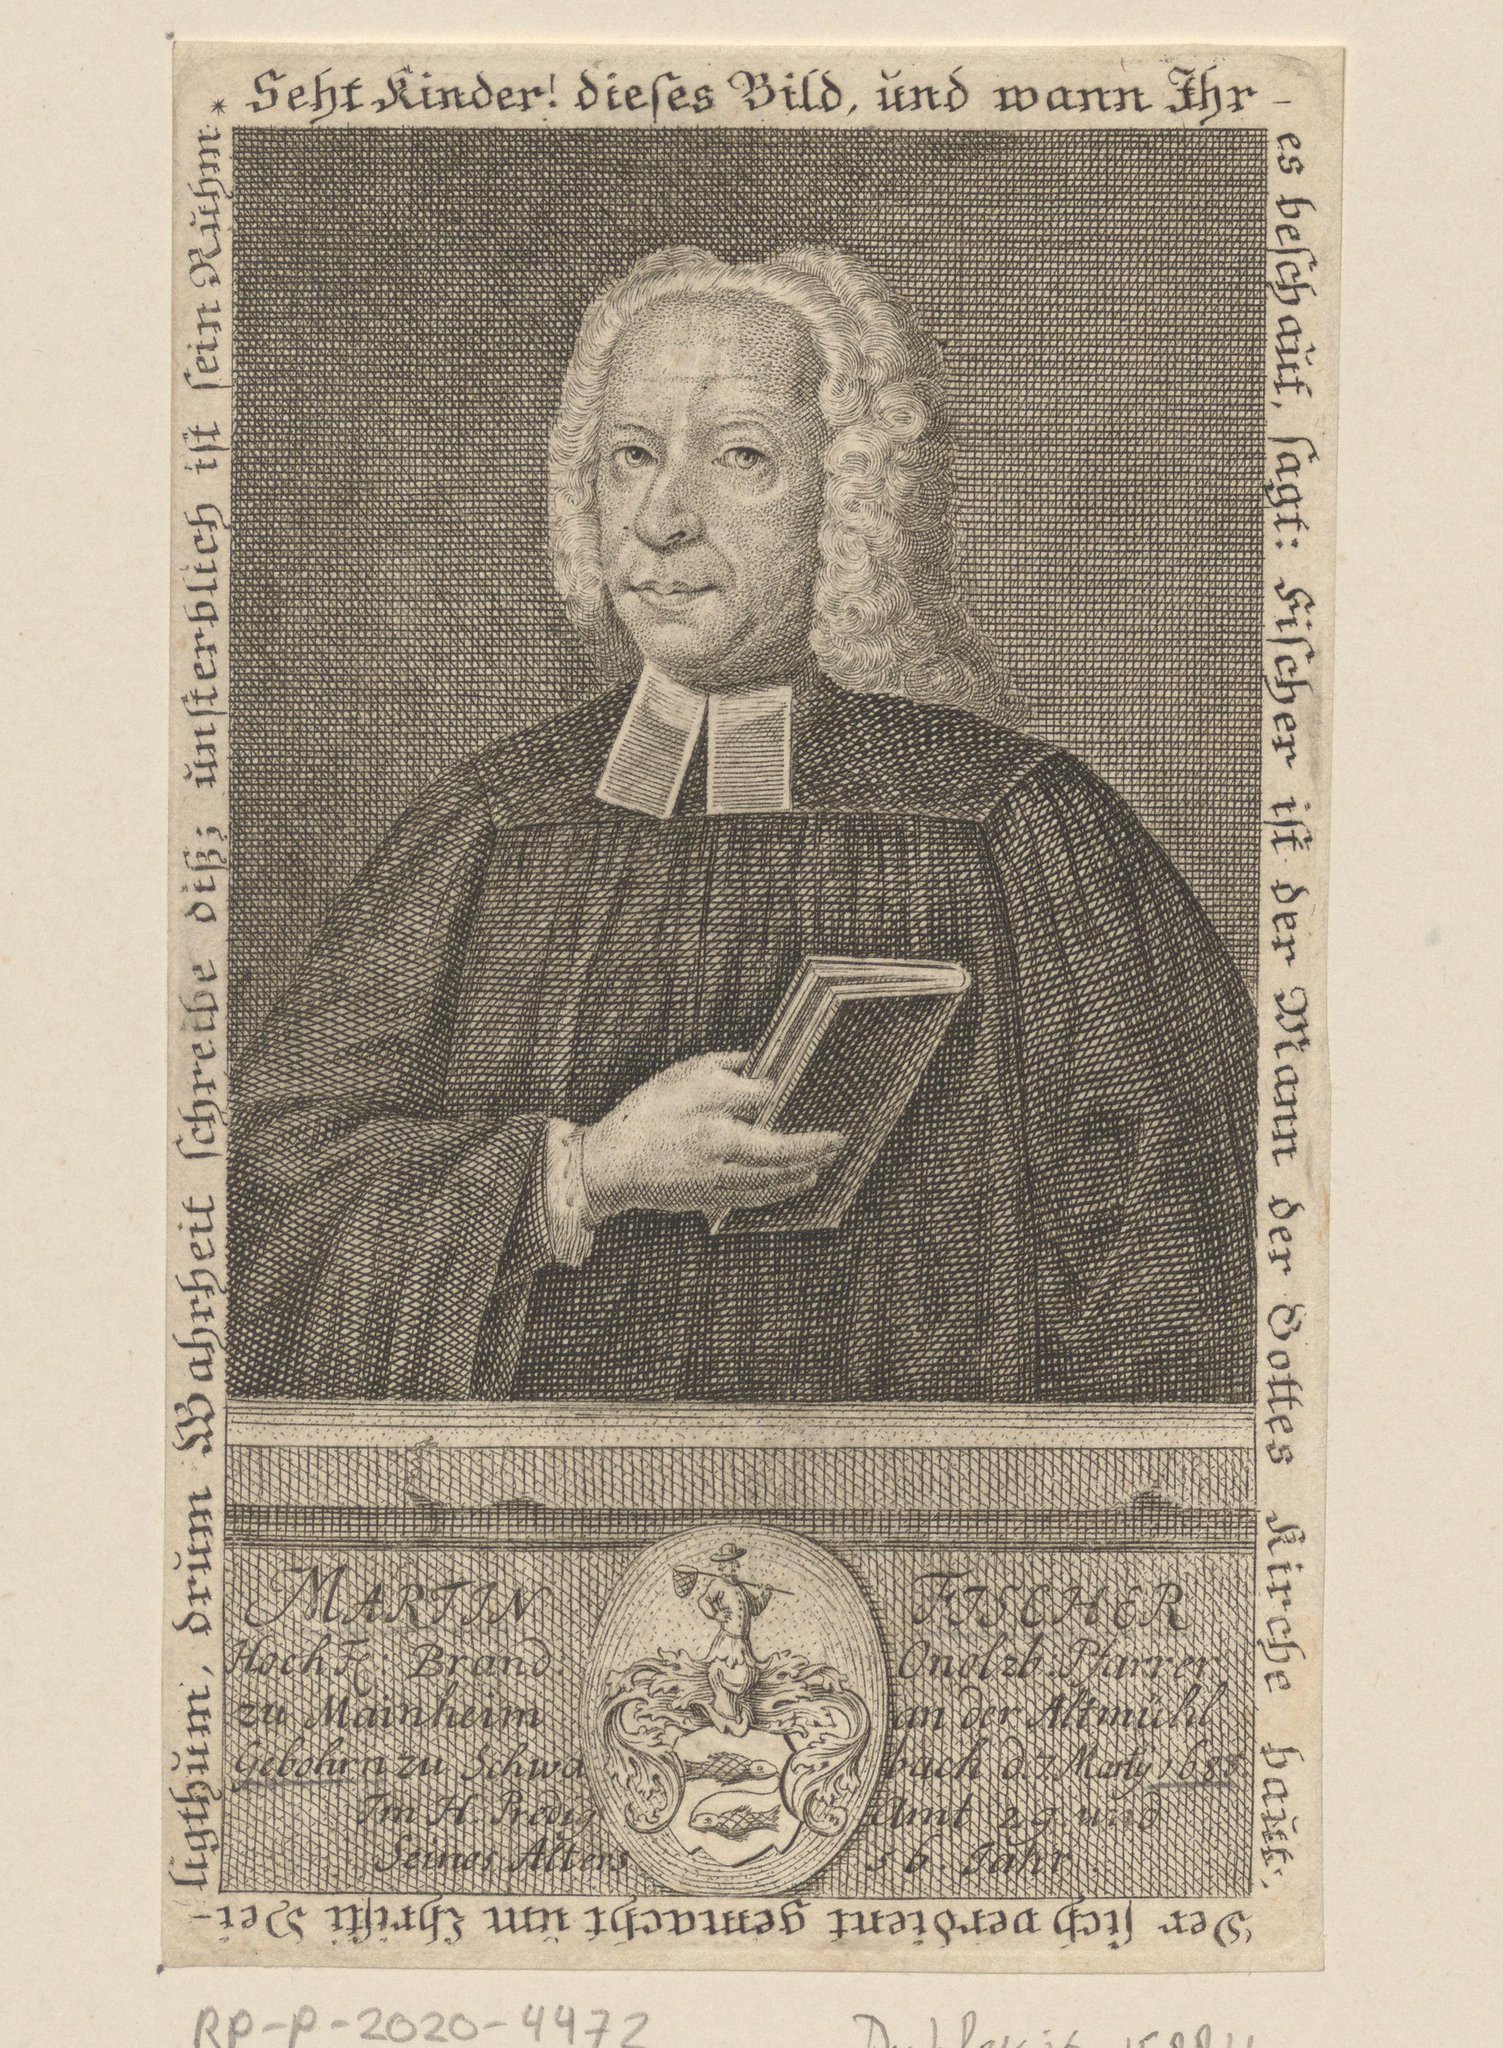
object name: print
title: Portret van Martin Fischer op 56-jarige leeftijd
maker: Anonymous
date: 1741-1750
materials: paper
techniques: engraving, etching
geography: germany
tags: historical persons, book, armorial bearing, heraldry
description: Met onderschrift in het Duits en Duits vers rondom het portret.